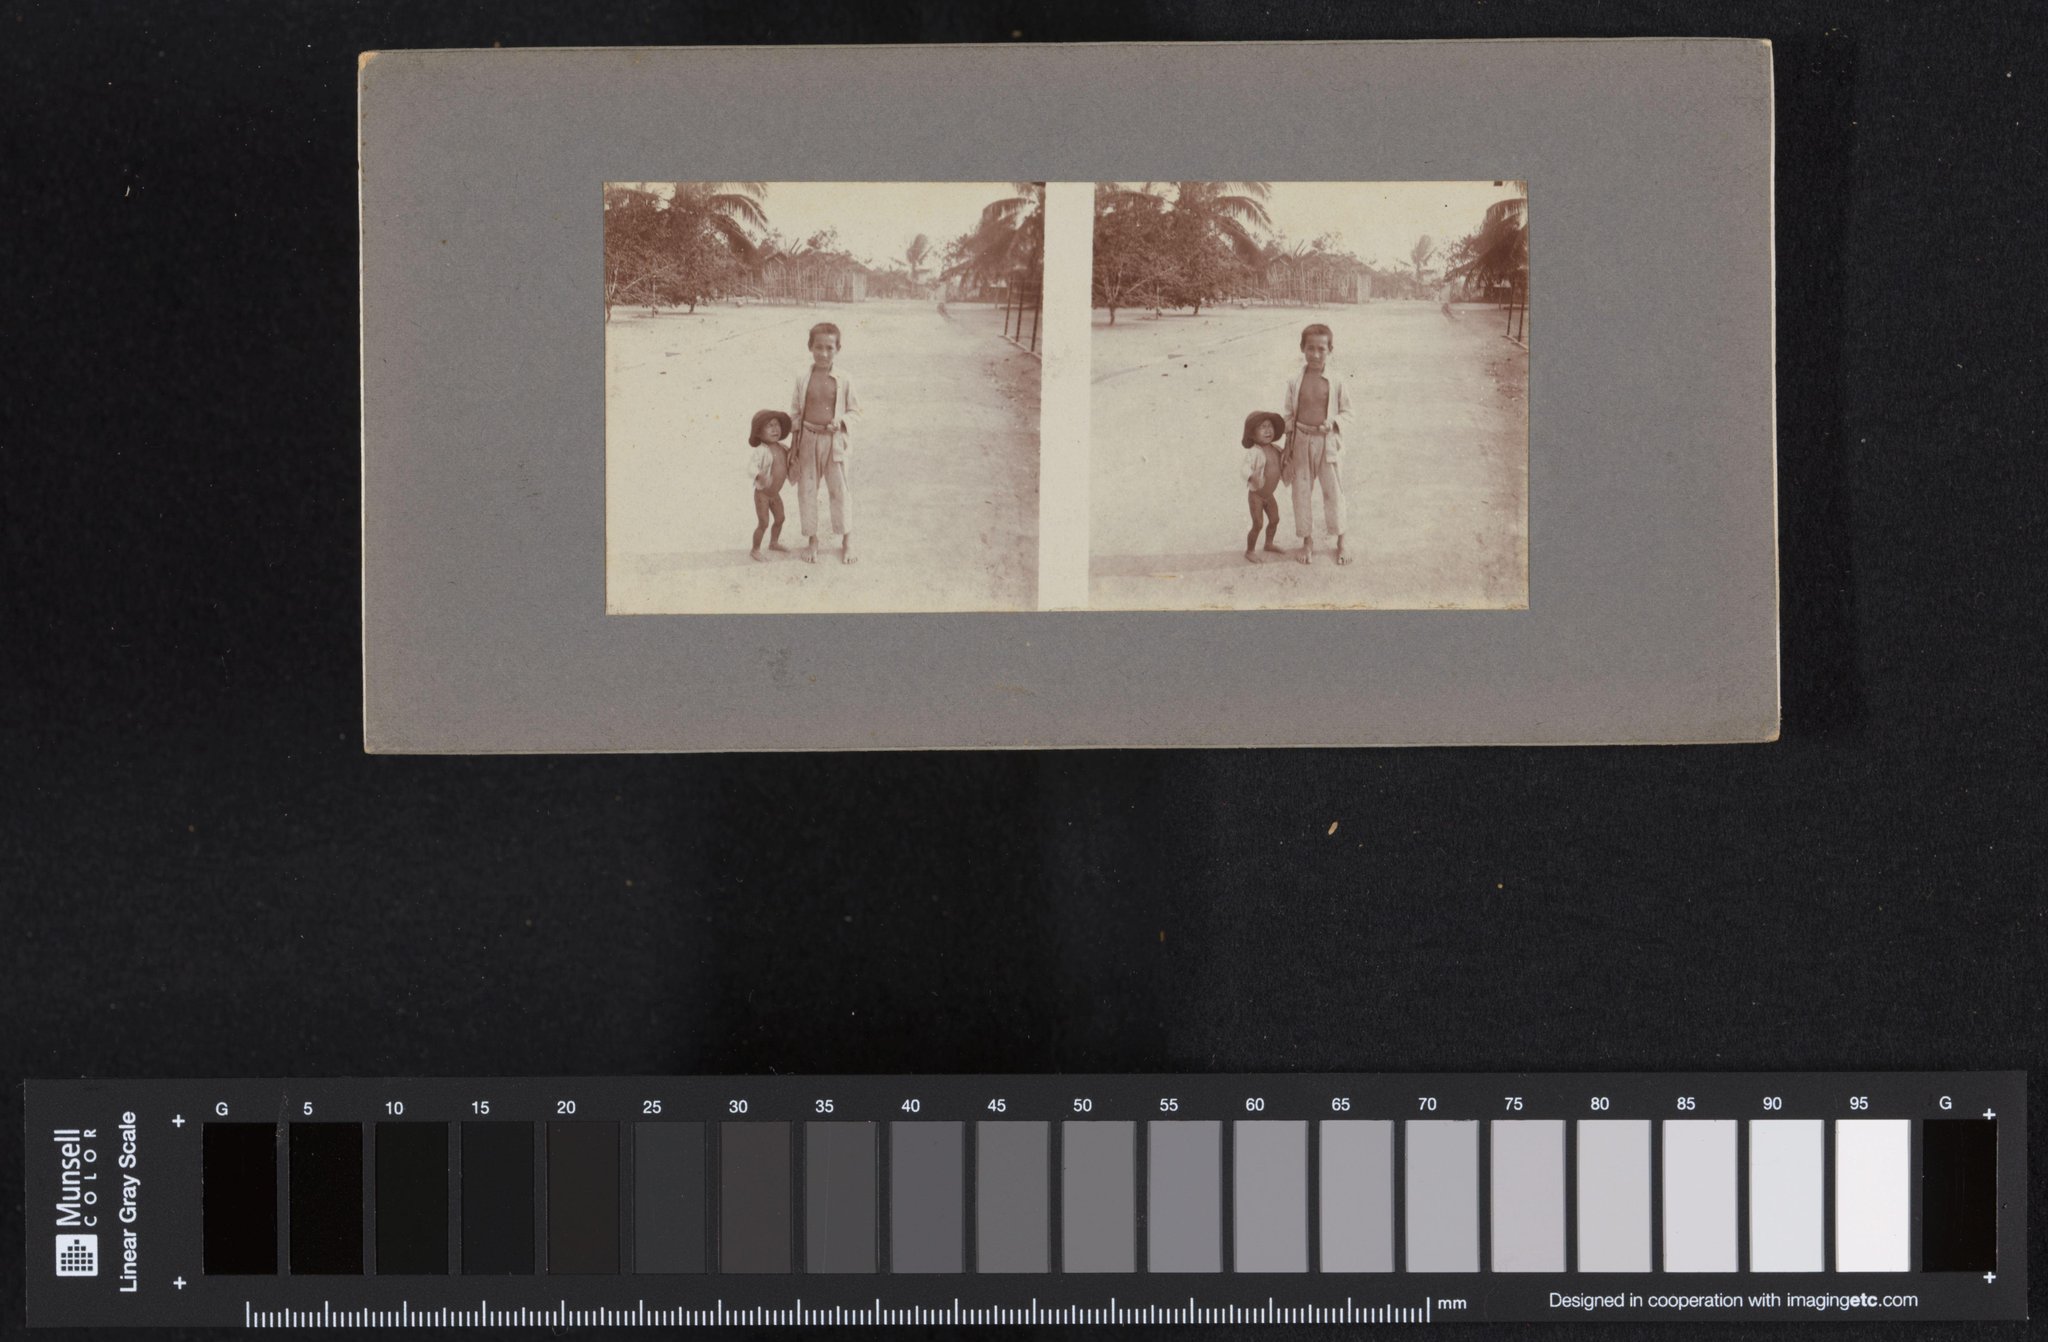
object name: stereograph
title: Kinderen op straat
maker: robert julius boers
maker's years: 1867-1932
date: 1900-1922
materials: cardboard, photographic support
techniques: gelatin silver print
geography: bangka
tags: robert julius boers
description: Twee Indische jongens op straat, waarschijnlijk op Banka. Onderdeel van een groep stereofoto's van Robert Julius Boers, chef van het staatsbedrijf de Banka-tinwinning op Banka, uit de periode ca. 1900-1922.